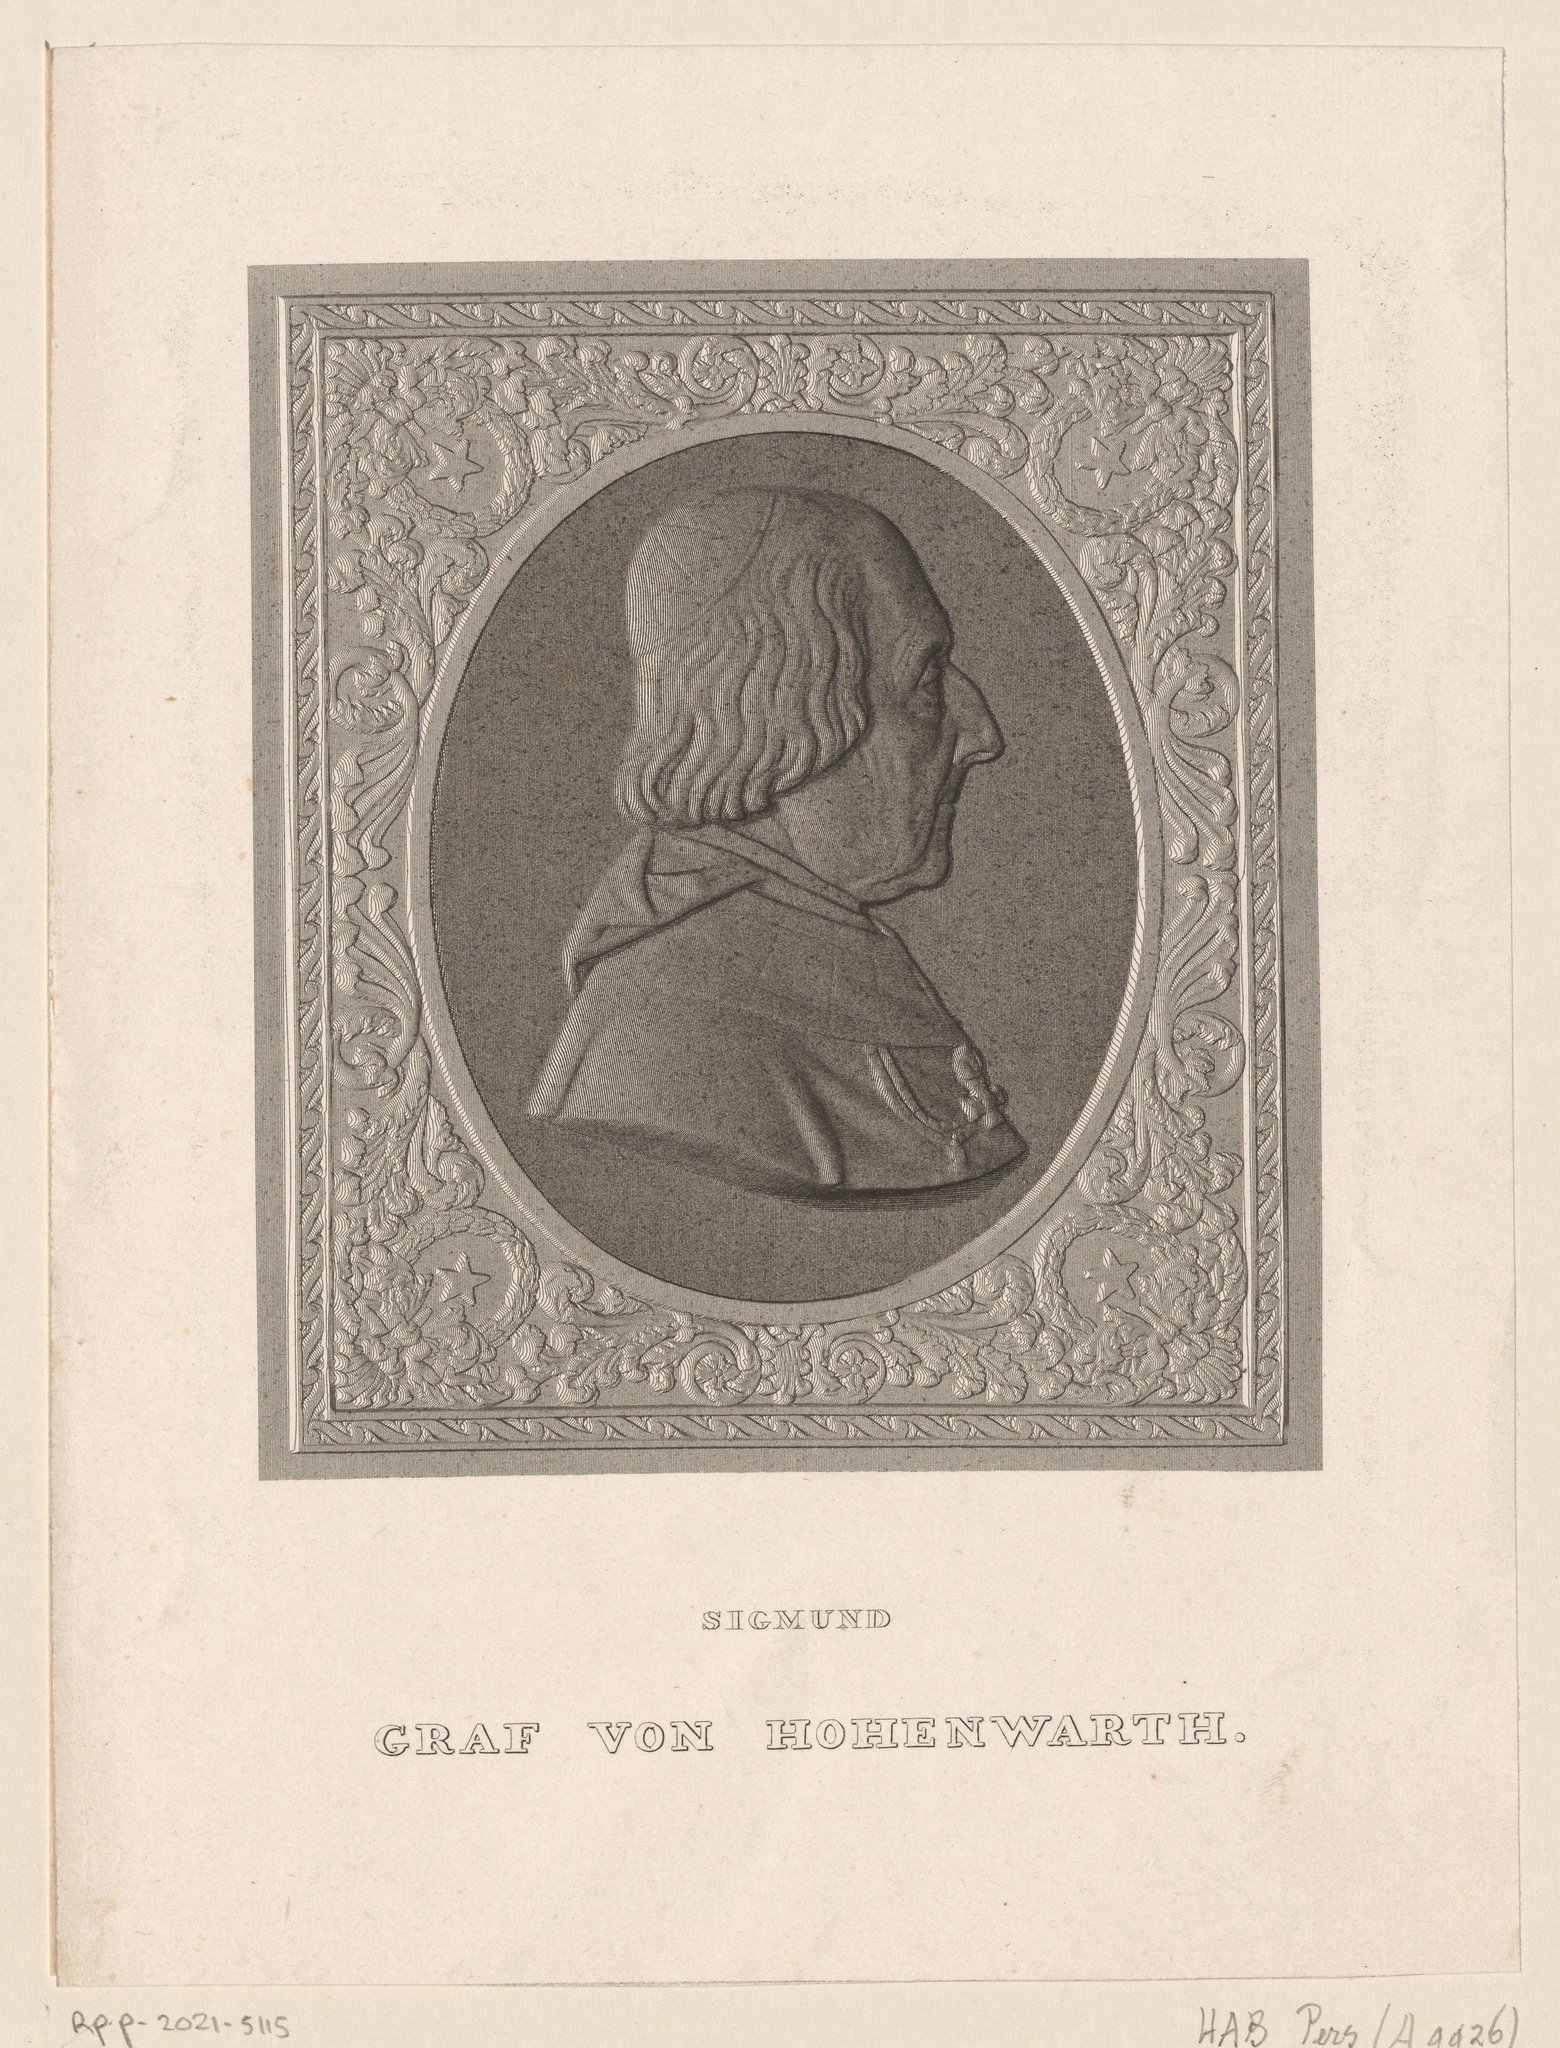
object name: print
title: Portret van Sigismund Anton von Hohenwart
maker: Anonymous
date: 1830-1899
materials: paper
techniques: relief engraving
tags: priest, adult man, historical persons